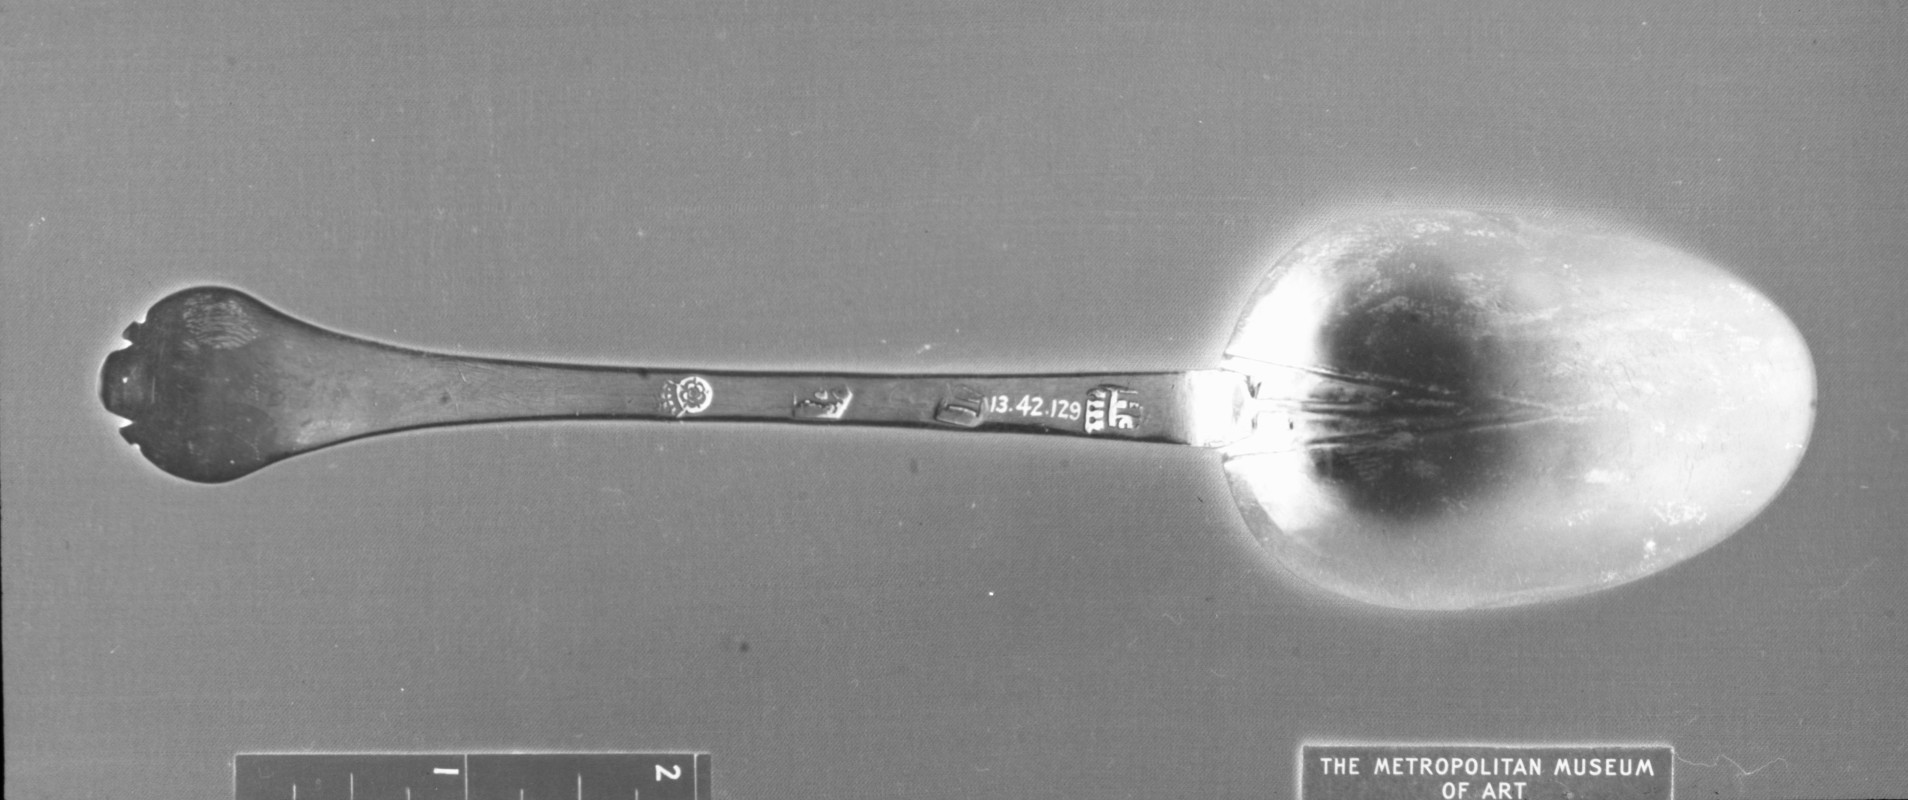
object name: spoon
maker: elizabeth hazelwood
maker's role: maker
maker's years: 1688-1697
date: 1696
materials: silver